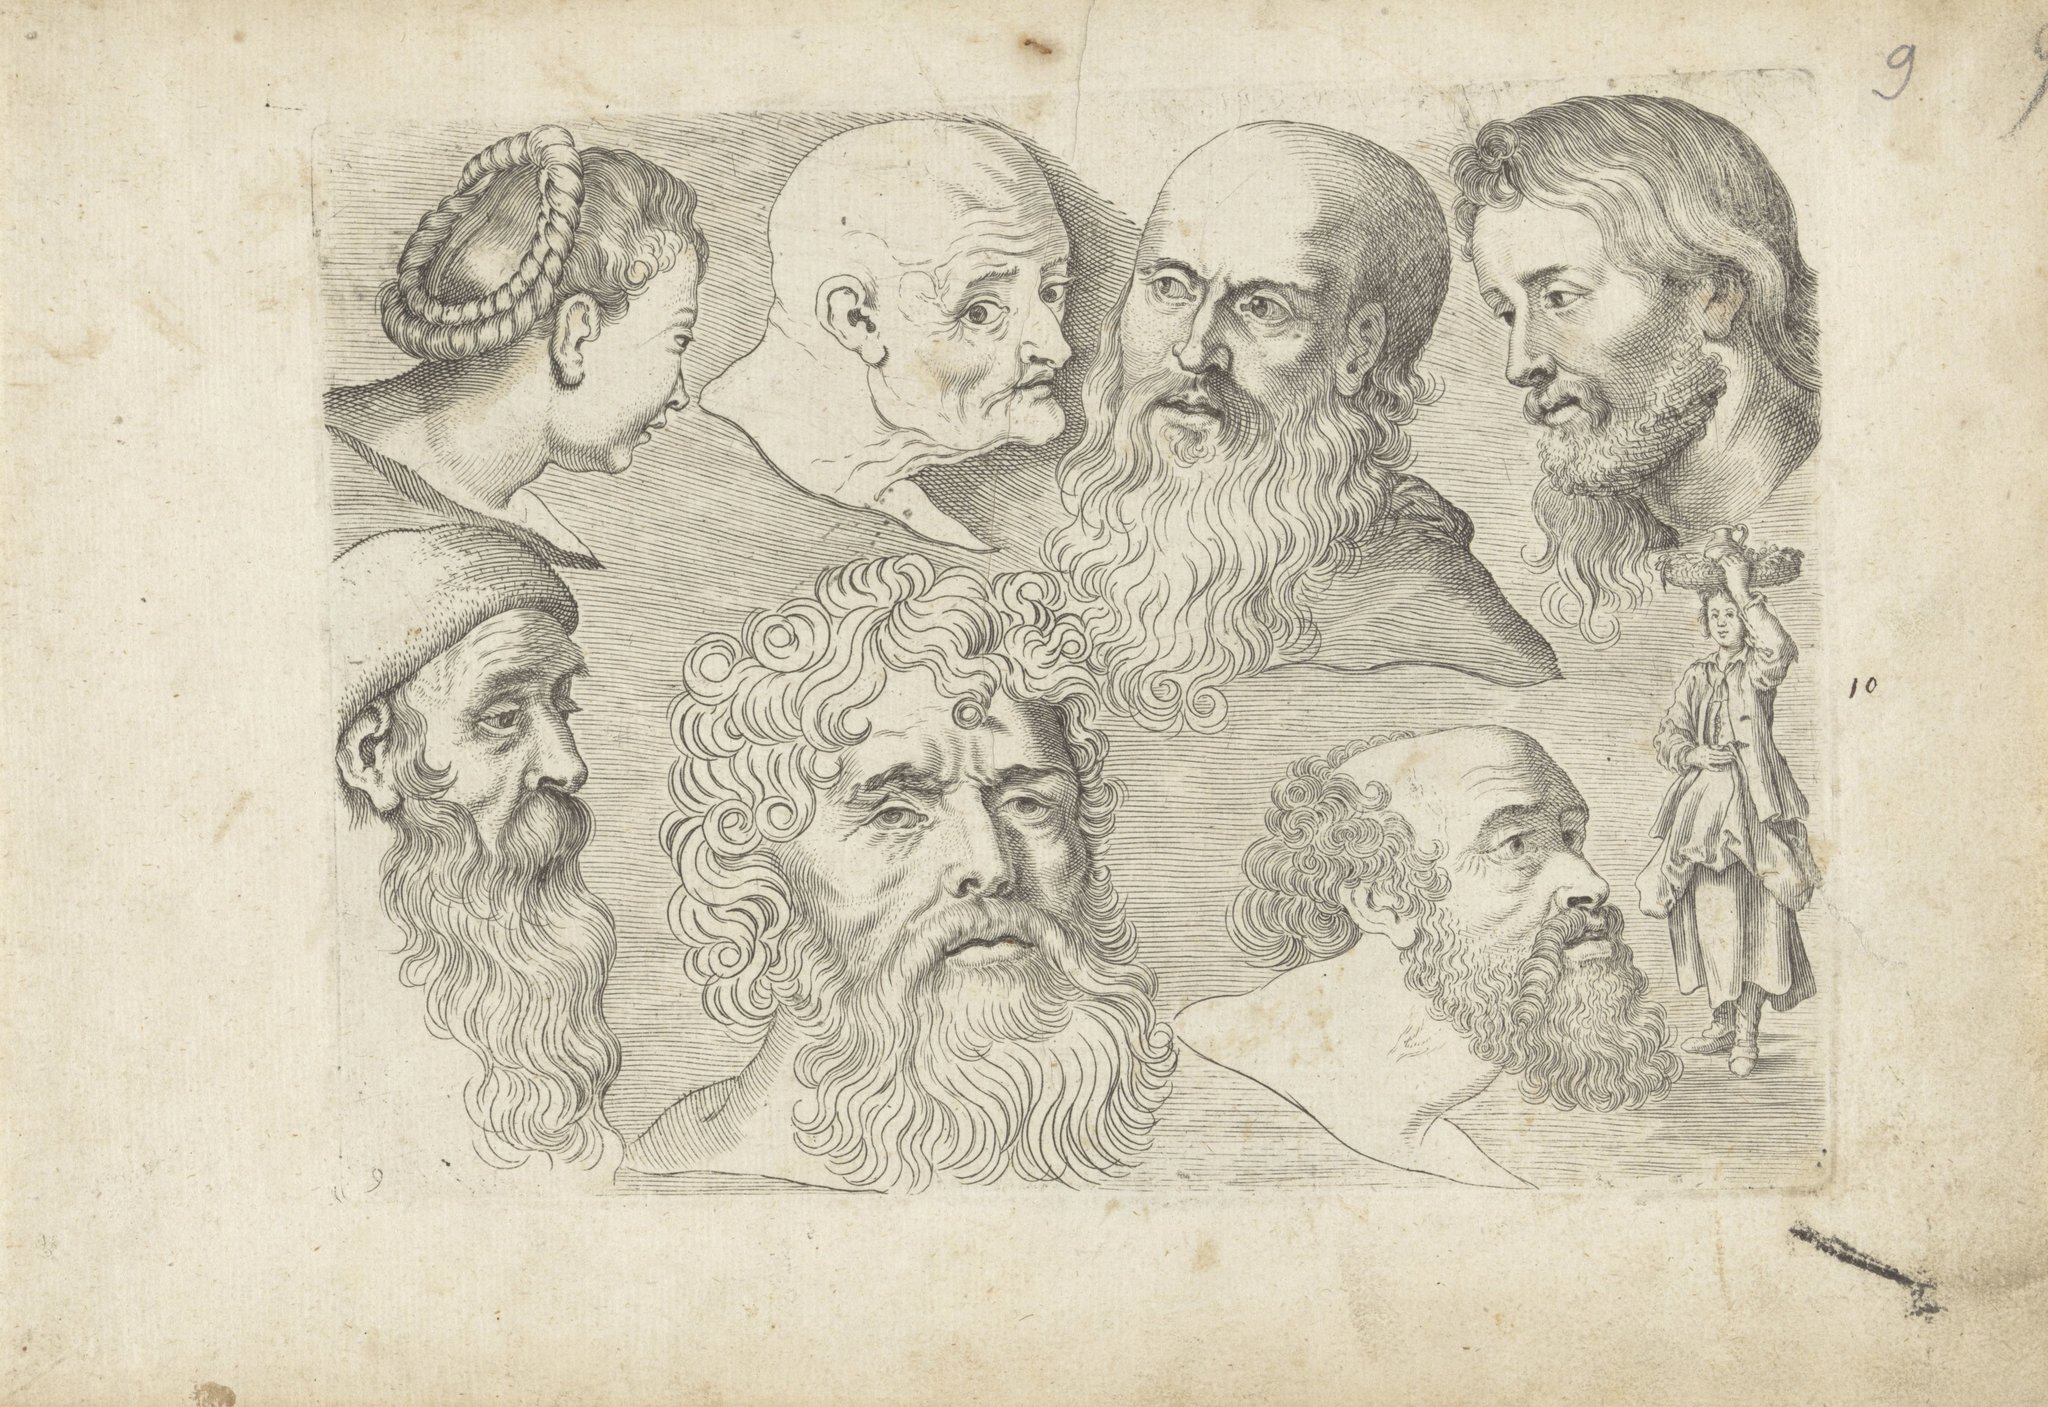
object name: print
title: Tekenvoorbeelden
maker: michael snijders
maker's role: print maker, publisher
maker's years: 1586-1672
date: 1610-1672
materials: paper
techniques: engraving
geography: antwerp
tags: head (human), model-books ~ implements of painter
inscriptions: collector's mark: Lugt 2228, collector's mark: Lugt 2760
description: Negende prent uit een serie tekenvoorbeelden van onbekende omvang. Studieblad met linksboven een vrouwenkop, mannenkoppen en rechtsonder een staande figuur.